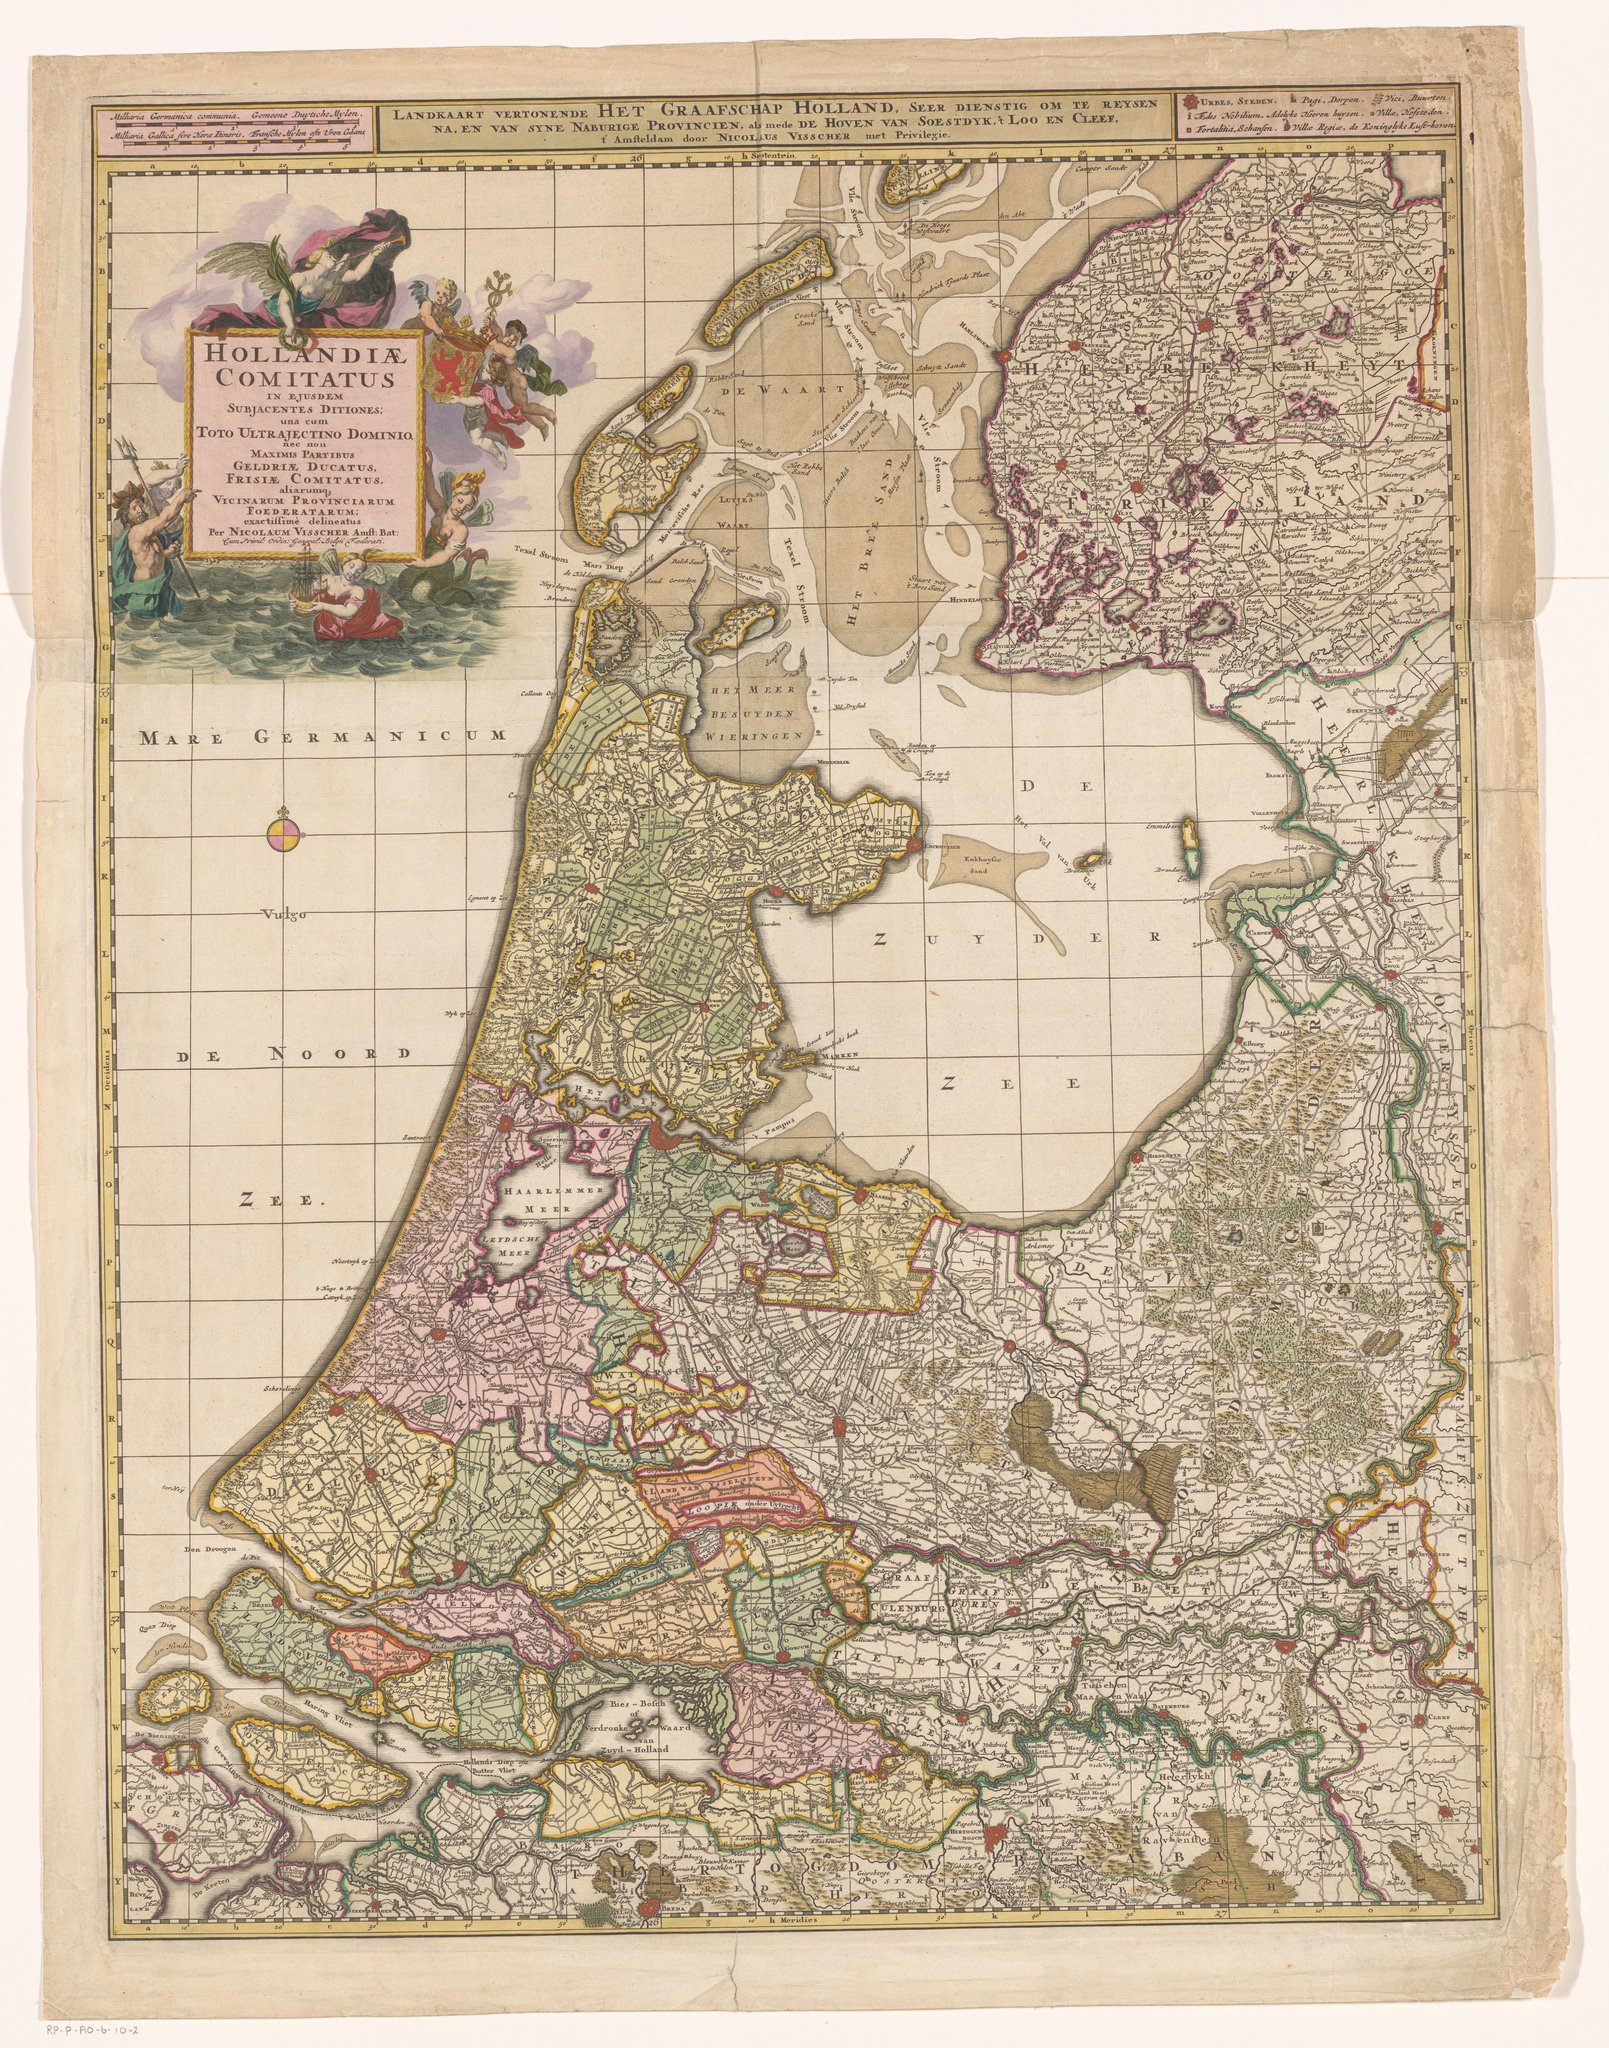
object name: print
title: Landkaart vertonende het graafschap Holland, seer dienstig om te reysen na, en van syne naburige provincien … / Hollandiae Comitatus in ejusdem subjacentes ditiones …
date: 1690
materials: paper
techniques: engraving, hand coloring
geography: amsterdam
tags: (story of) neptune (poseidon), coat of arms (as symbol of the state, etc.), maps of separate countries or regions, merman - aa - mermaid, siren, fame; 'fama', 'fama buona', 'fama chiara' (ripa), holland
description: Kaart van het graafschap Holland en omliggende gebieden. Helemaal boven in het midden de Nederlandse titel. Links daarvan twee schaalstokken: Milliaria Germanica communia / Gemeene Duytsche mylen; Milliaria Gallica sive horae itineris / Fransche mylen ofte uren gaens. Rechts van die titel de legenda. Linksboven op de kaart een cartouche met de Latijnse titel. Daaromheen Fama, putti met het wapen van het graafschap Holland, zeemeerminnen en Neptunus. De kaart is voorzien van een zoekrooster en een gradenverdeling langs de randen.